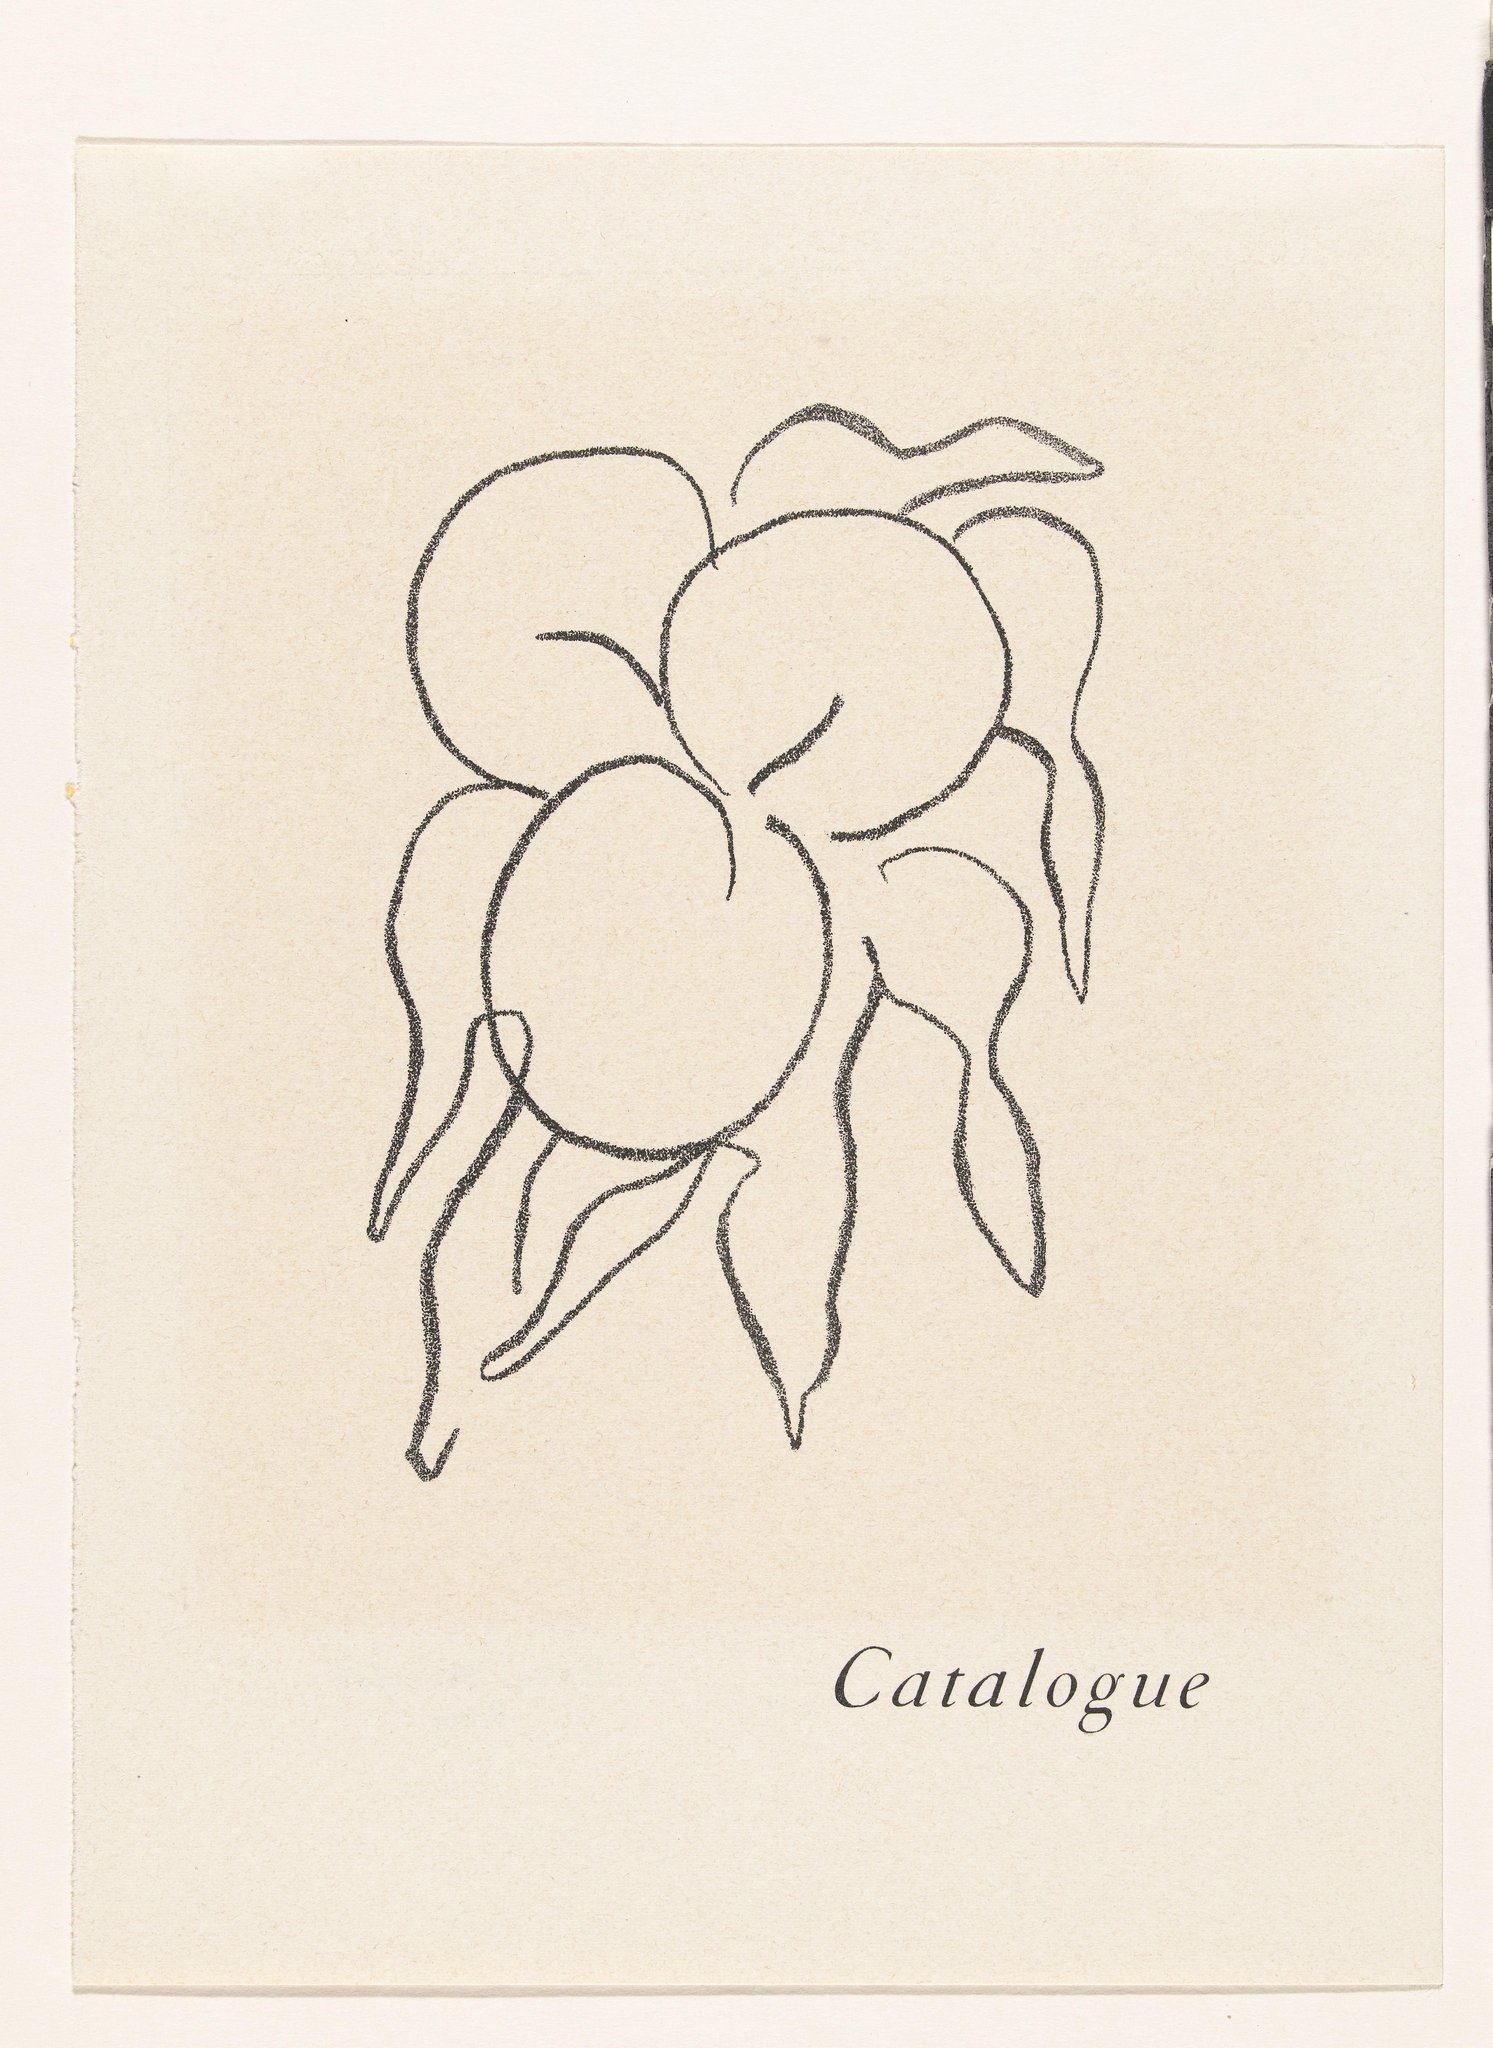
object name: print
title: Fruit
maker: henri matisse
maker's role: print maker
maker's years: 1869-1954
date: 1946-1964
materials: paper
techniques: lithograph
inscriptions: collector's mark: Lugt 2228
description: ‘In my drawings of that time you can see that I was trying to be like Matisse, without imitating him. I took over what I could use.’ While Bruna in no way pretended to measure up to Matisse, there are evident similarities – and differences – between their work. Matisse’s lines are rounder, more fluid, and display a greater variation in thickness. Bruna included more details